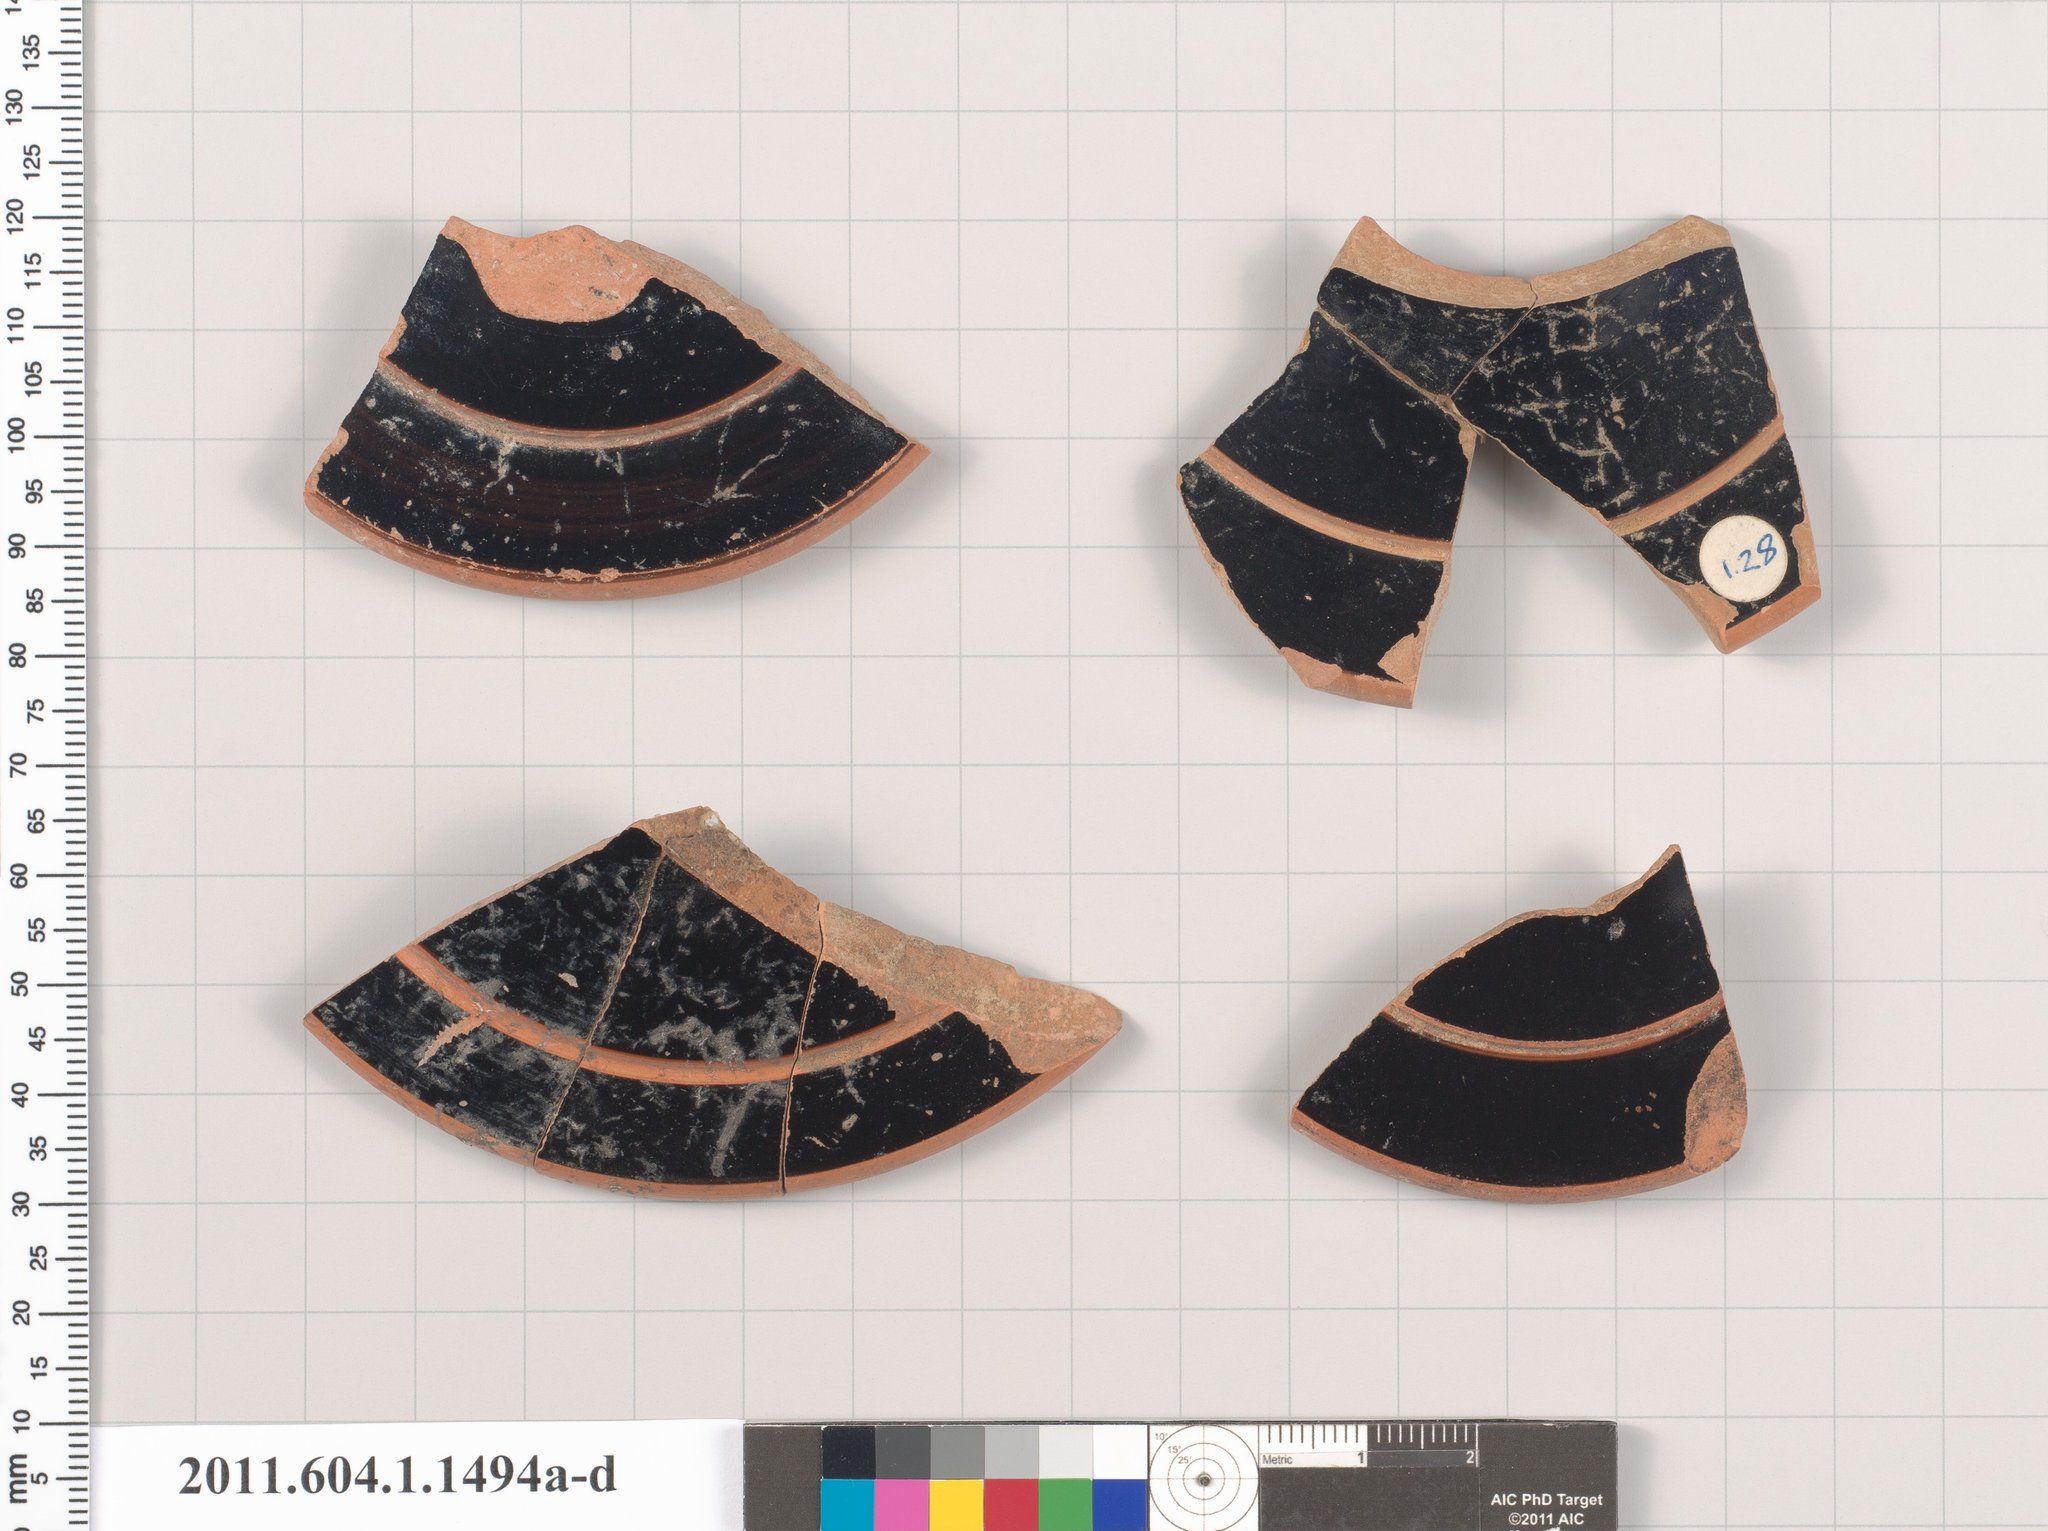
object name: kylix fragment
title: Terracotta fragments of kylikes (drinking cups)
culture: greek, attic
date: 500-401 BCE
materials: terracotta